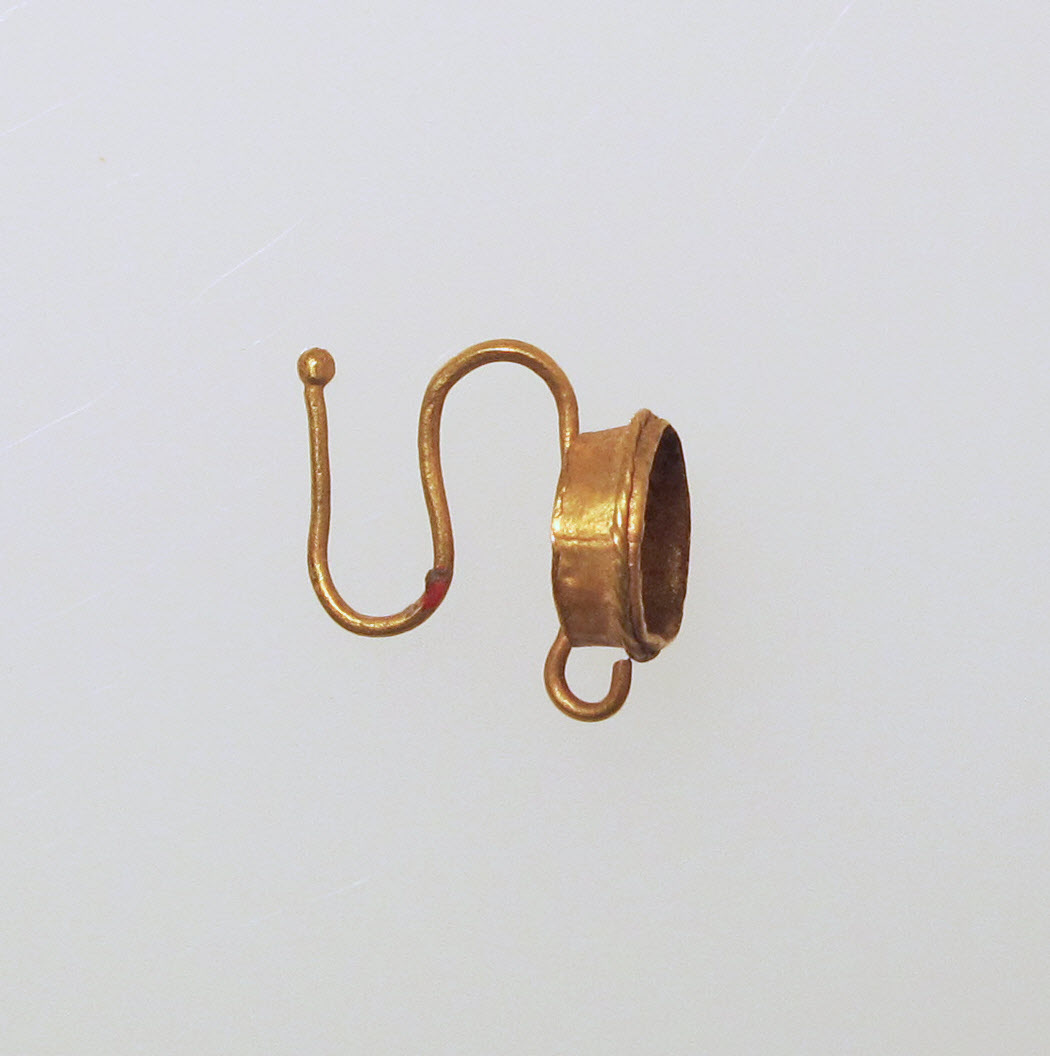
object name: earring hook type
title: Earring-hook type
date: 7000 BCE-330 CE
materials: gold